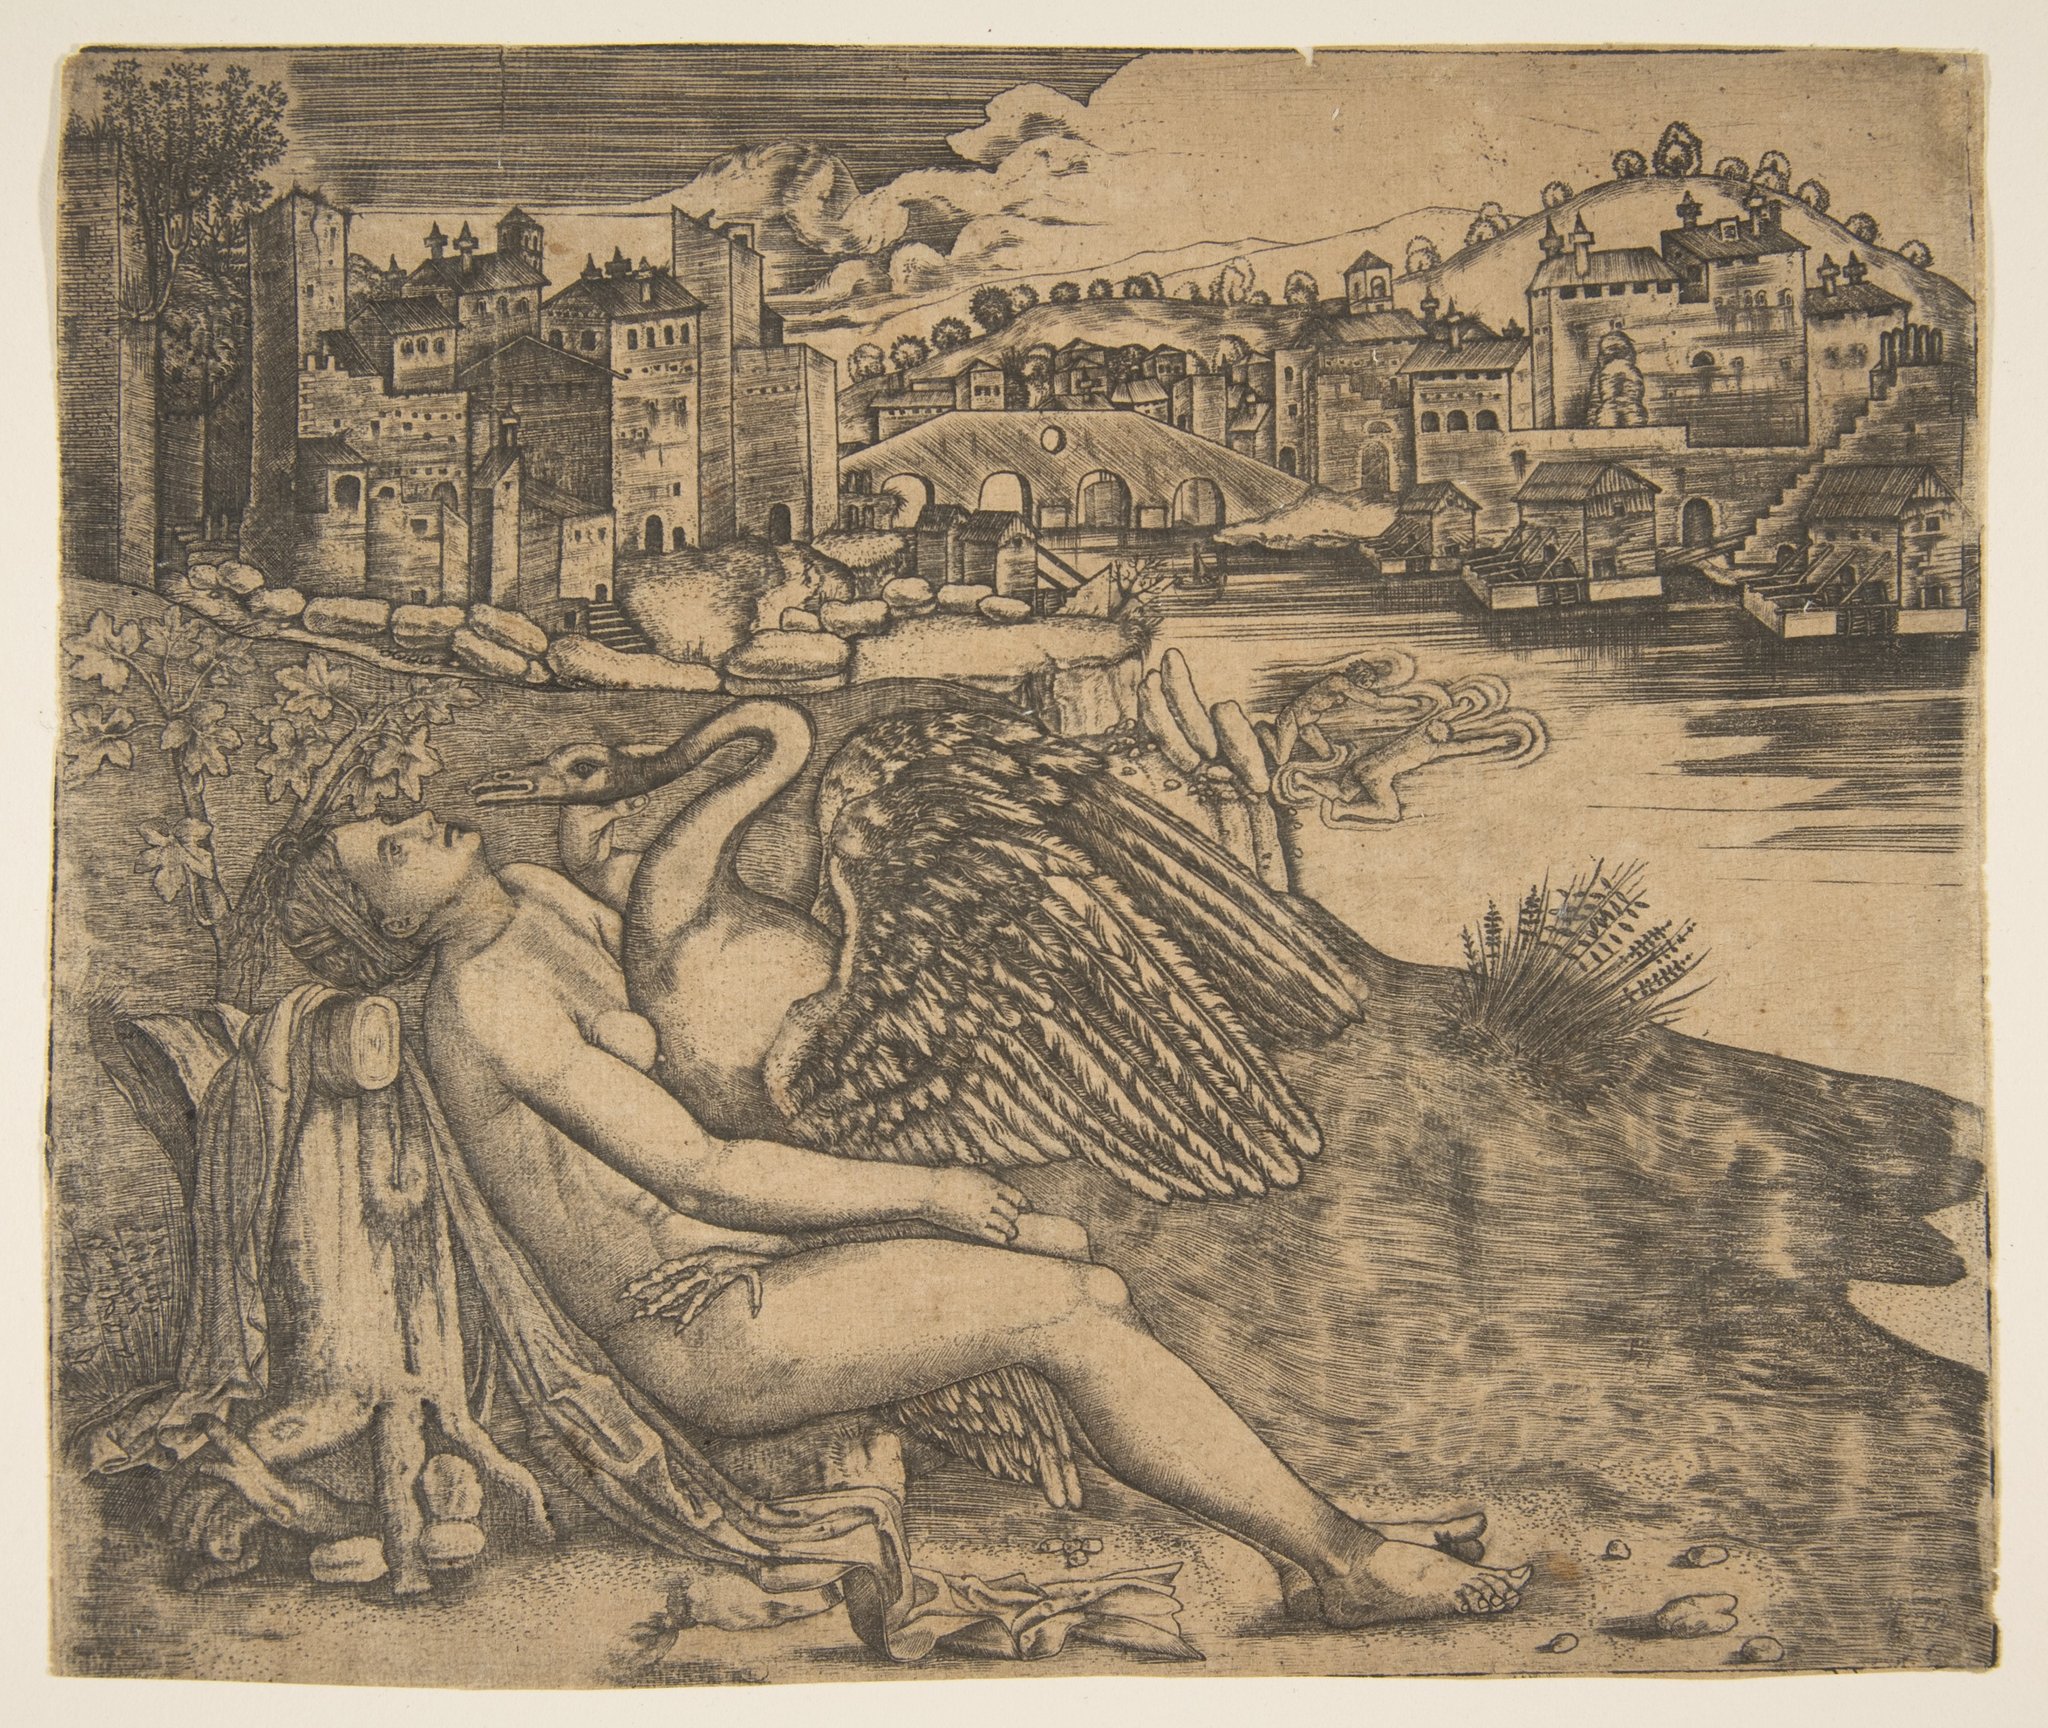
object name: print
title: Naked woman (Leda) and swan (Zeus) embrace on a river bank; two figures jump into the water at middle ground; a town and bridge in the background.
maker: anonymous, italian, 16th century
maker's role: artist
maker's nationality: italian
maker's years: 1550-1600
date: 1501-1533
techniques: engraving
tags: bridges,towns,female nudes,swans,rivers